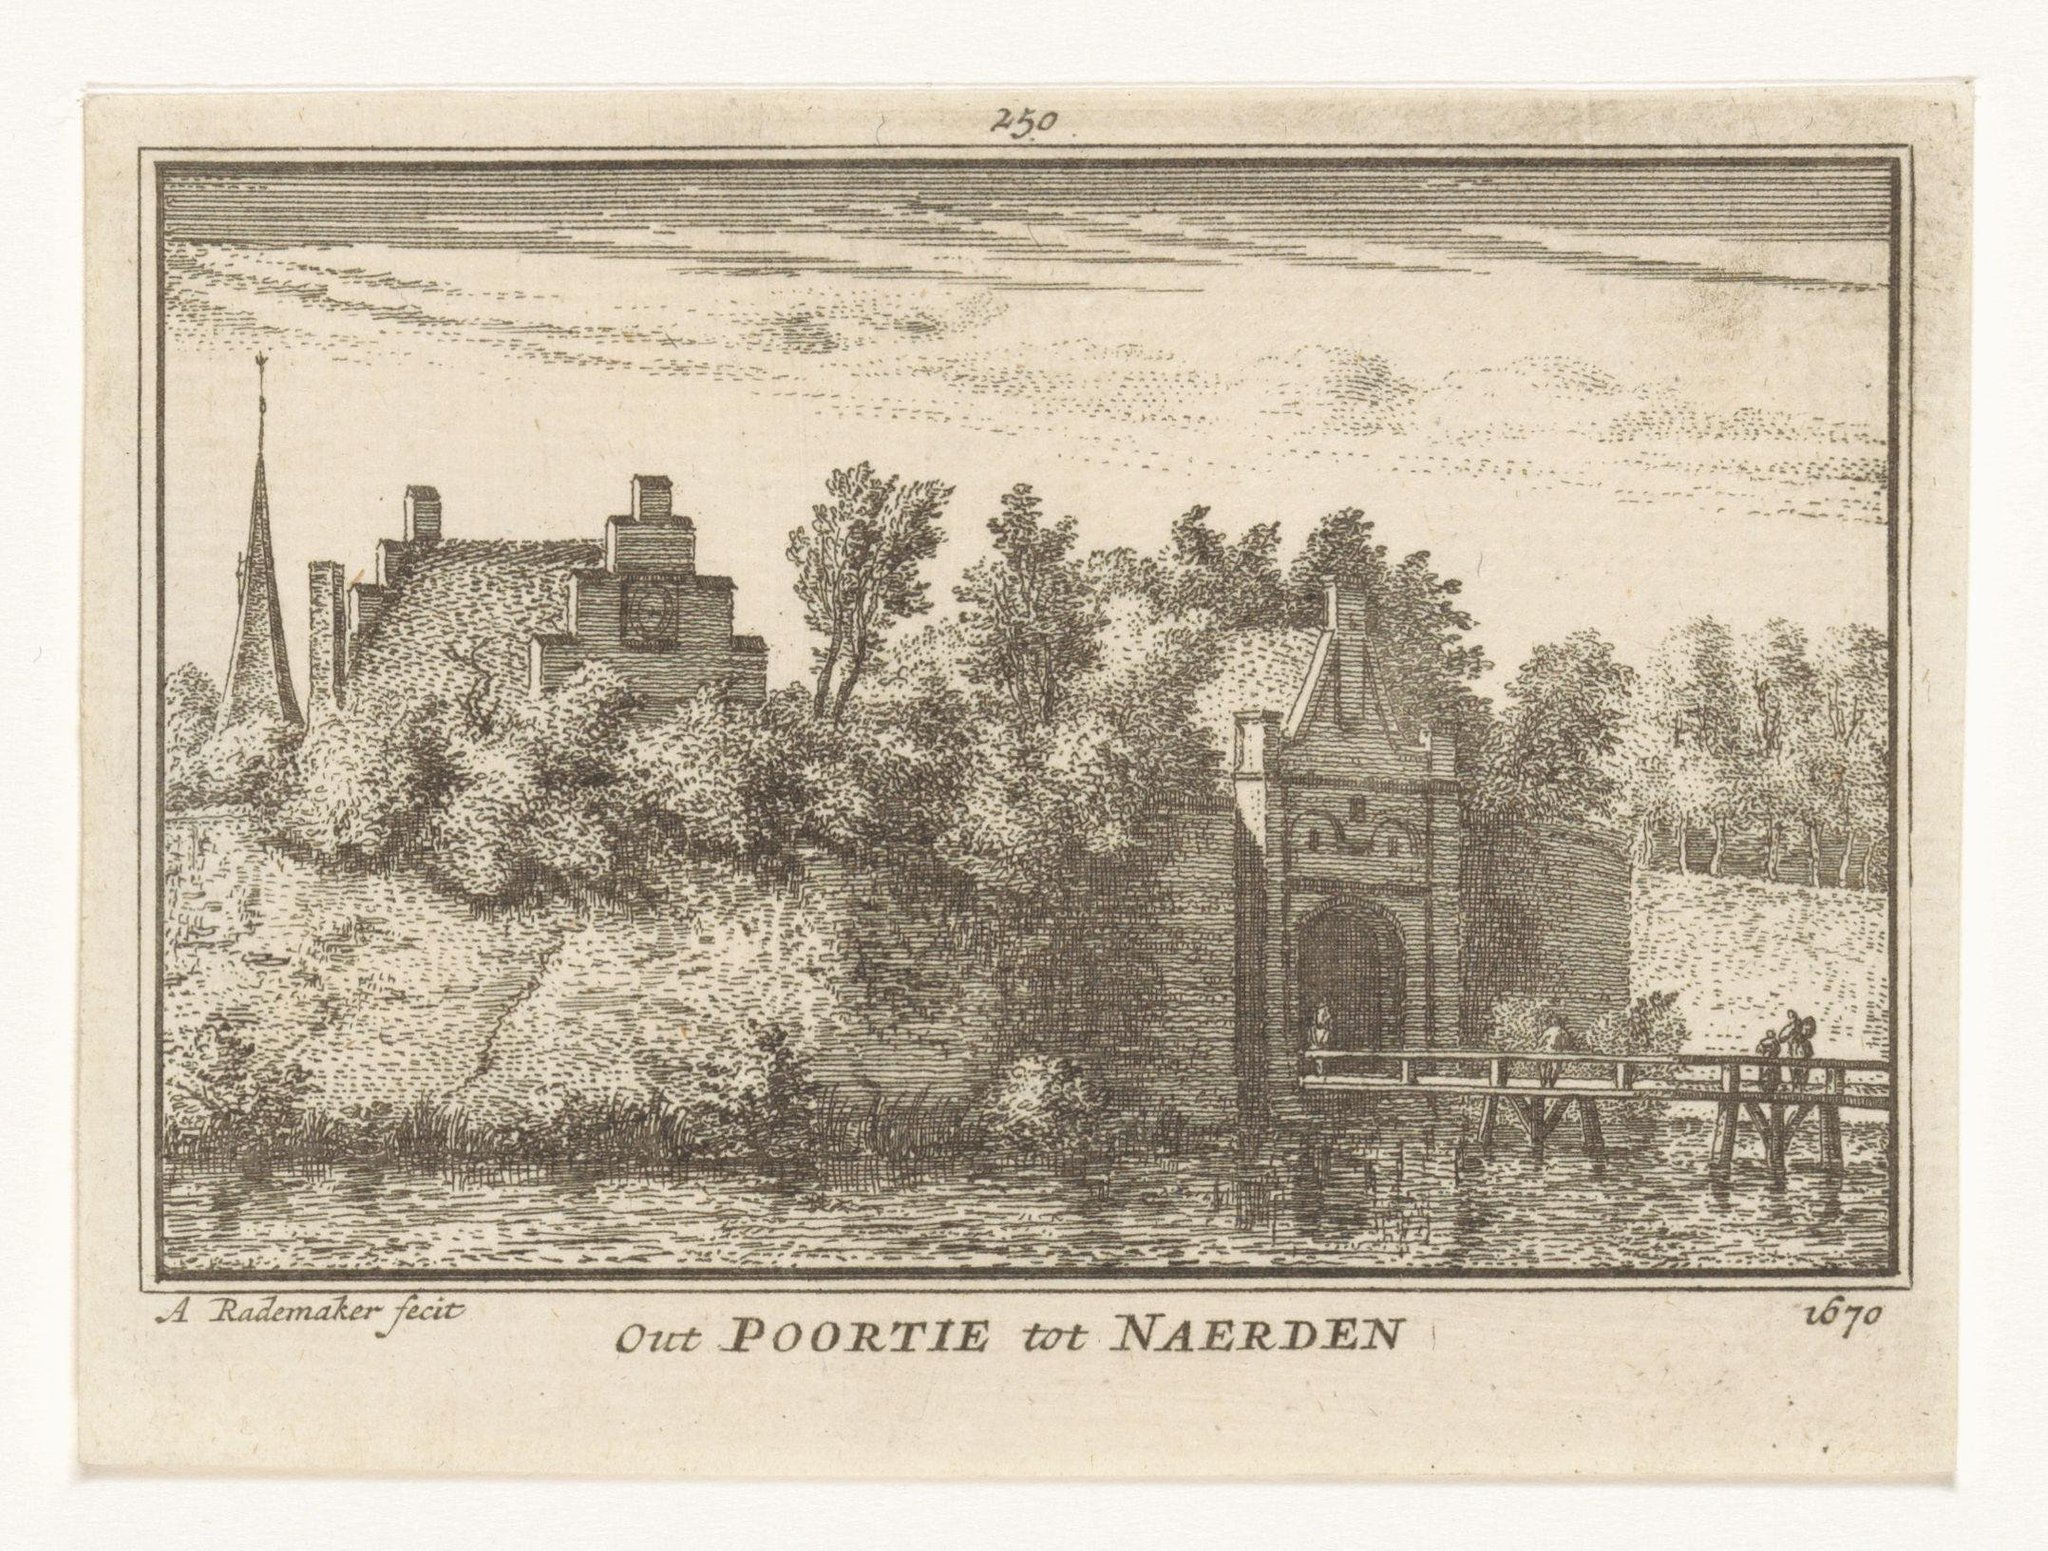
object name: book illustration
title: Gezicht op Bussum, 1739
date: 1757-1792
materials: paper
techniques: engraving, etching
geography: haarlem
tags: prospect of village, silhouette of village, church (exterior)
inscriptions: collector's mark: Lugt 195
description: Prent ook gebruikt in: Het verheerlykt Nederland of kabinet van hedendaagsche gezigten van steden, dorpen (…). 9 delen. Amsterdam: Isaak Tirion en weduwe Isaak Tirion, 1745-1774, dl. 6 (1757), ill. 432. Of in: Nederlandsche tafereelen; of eene keurige verzameling van negen honderd fraaije gezigten van steden, dorpen, sloten, oudheden (….). 9 delen. Amsterdam: Jan de Groot, 1792, dl. 6, ill. 432. Uit welke druk het huidige exemplaar precies komt is niet na te gaan.